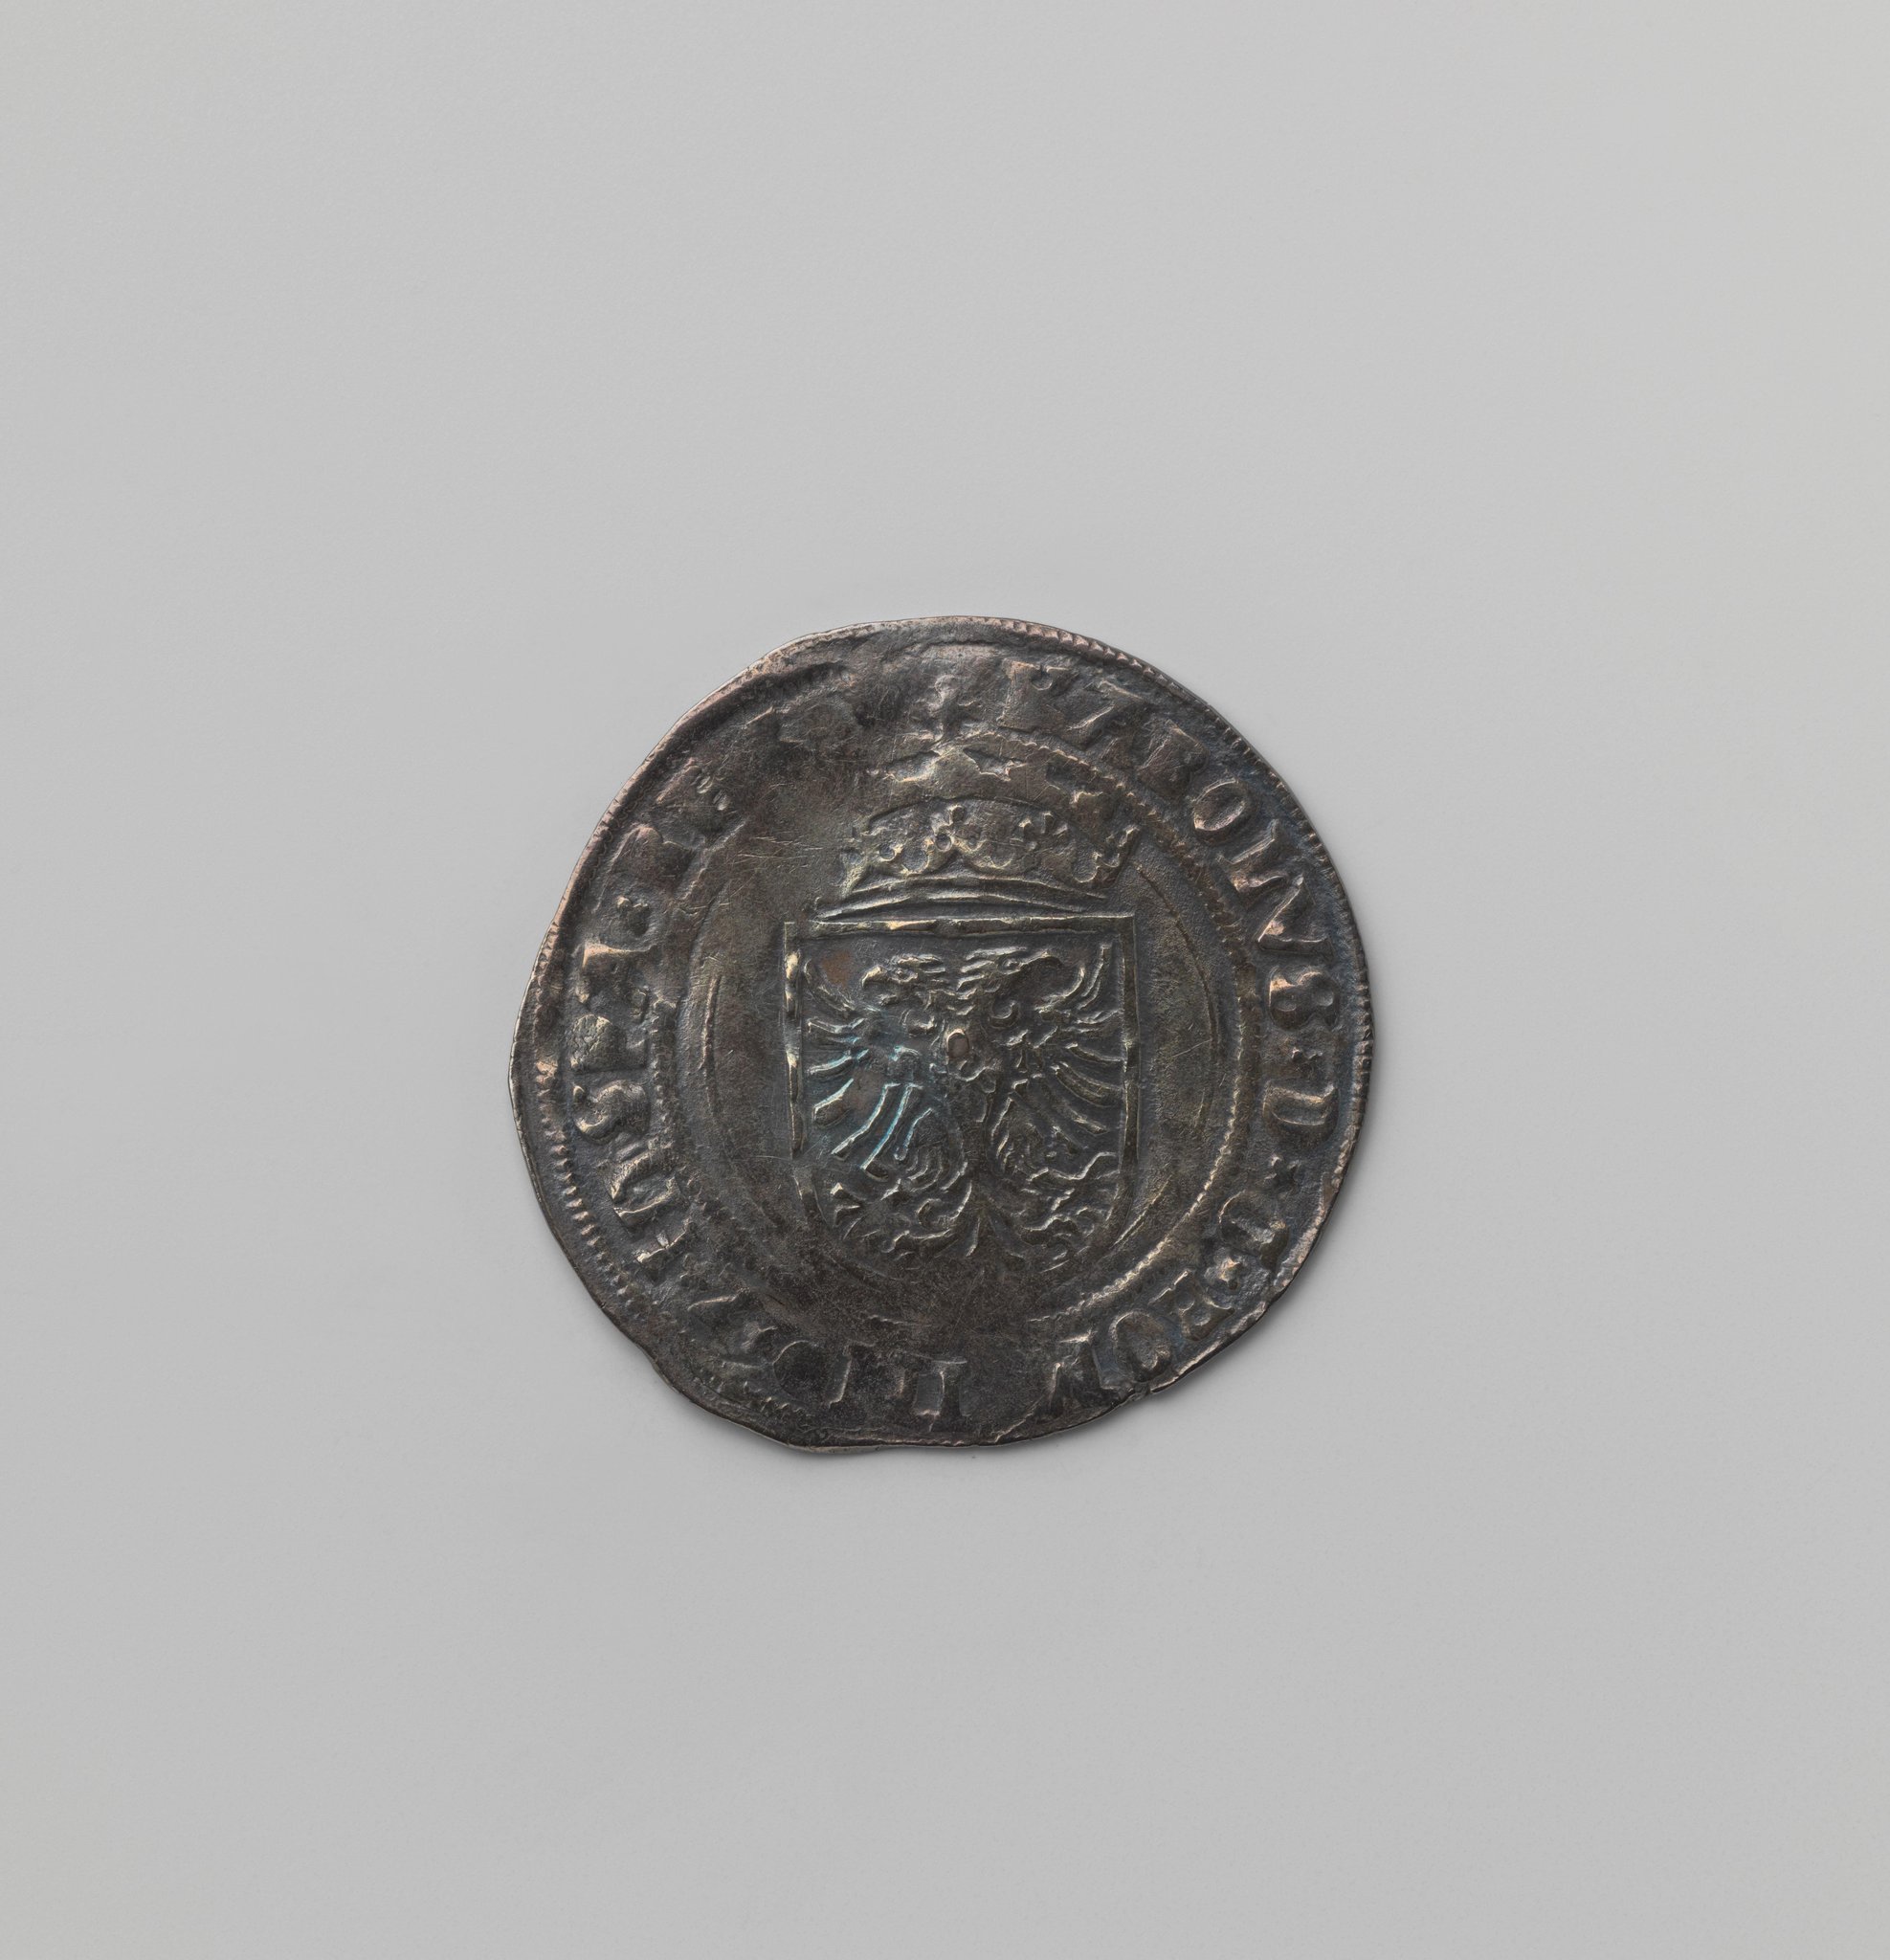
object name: real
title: Brabant, Karel V, zilveren reaal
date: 1521-1545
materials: silver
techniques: striking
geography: antwerp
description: Zilveren munt. Voorzijde: gekroond wapenschild van het Duitse keizerrijk. Aan het eind van het omschrift hand. Keerzijde: gekroond samengesteld wapenschild op lang gebloemd en gevoet kruis.